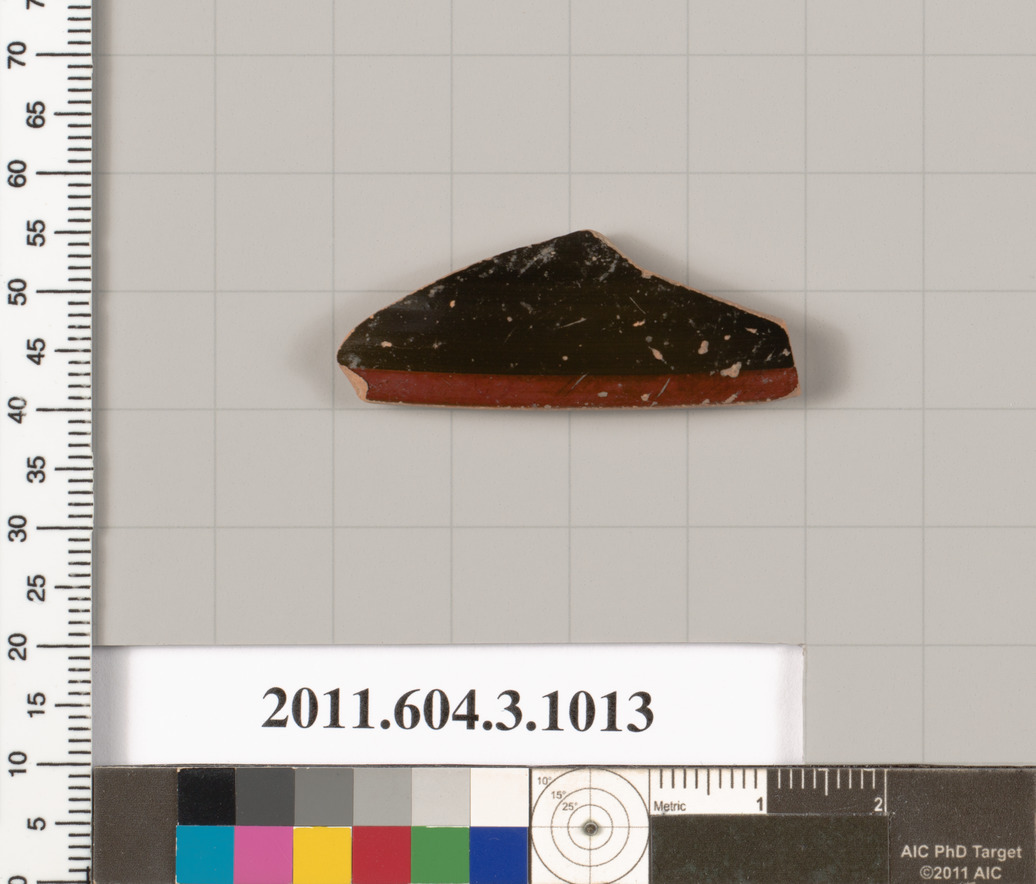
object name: lekanis fragment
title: Terracotta fragment of a lekanis (covered dish)?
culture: greek, attic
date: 600-501 BCE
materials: terracotta